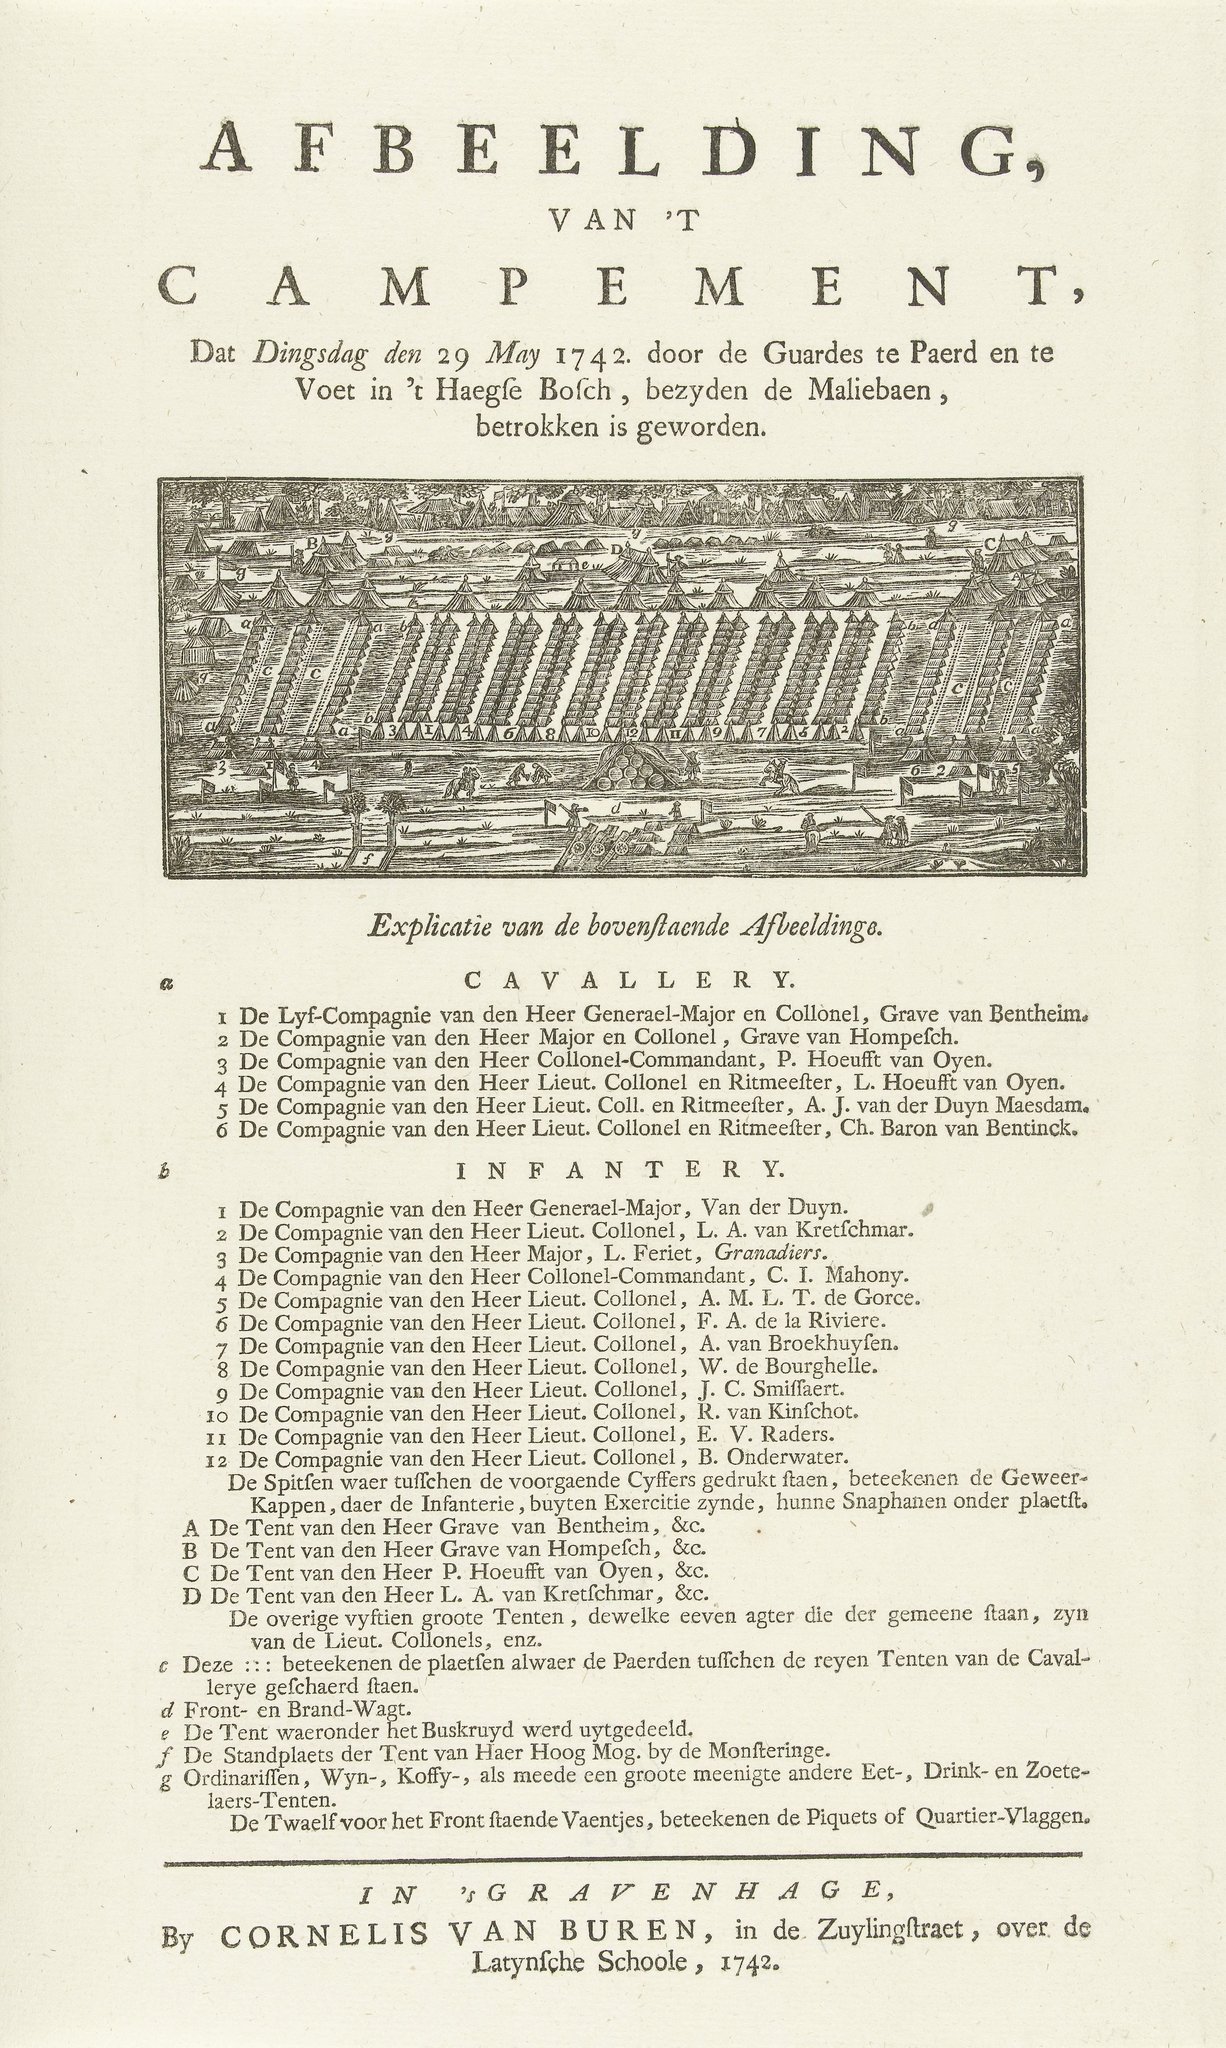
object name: print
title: Kampement bij Den Haag, 1742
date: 1742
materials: paper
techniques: letterpress printing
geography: northern netherlands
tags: (military) camp with tents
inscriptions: collector's mark: Lugt 2228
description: Gezicht op de grote legeroefening het Kampement te Den Haag, een legerkamp opgeslagen op bevel van de Staten van Holland en West-Friesland in het Haagse Bos bij Den Haag, 29 mei 1742. Op het blad onder de plaat de legenda's 1-12, A-D en c-g.